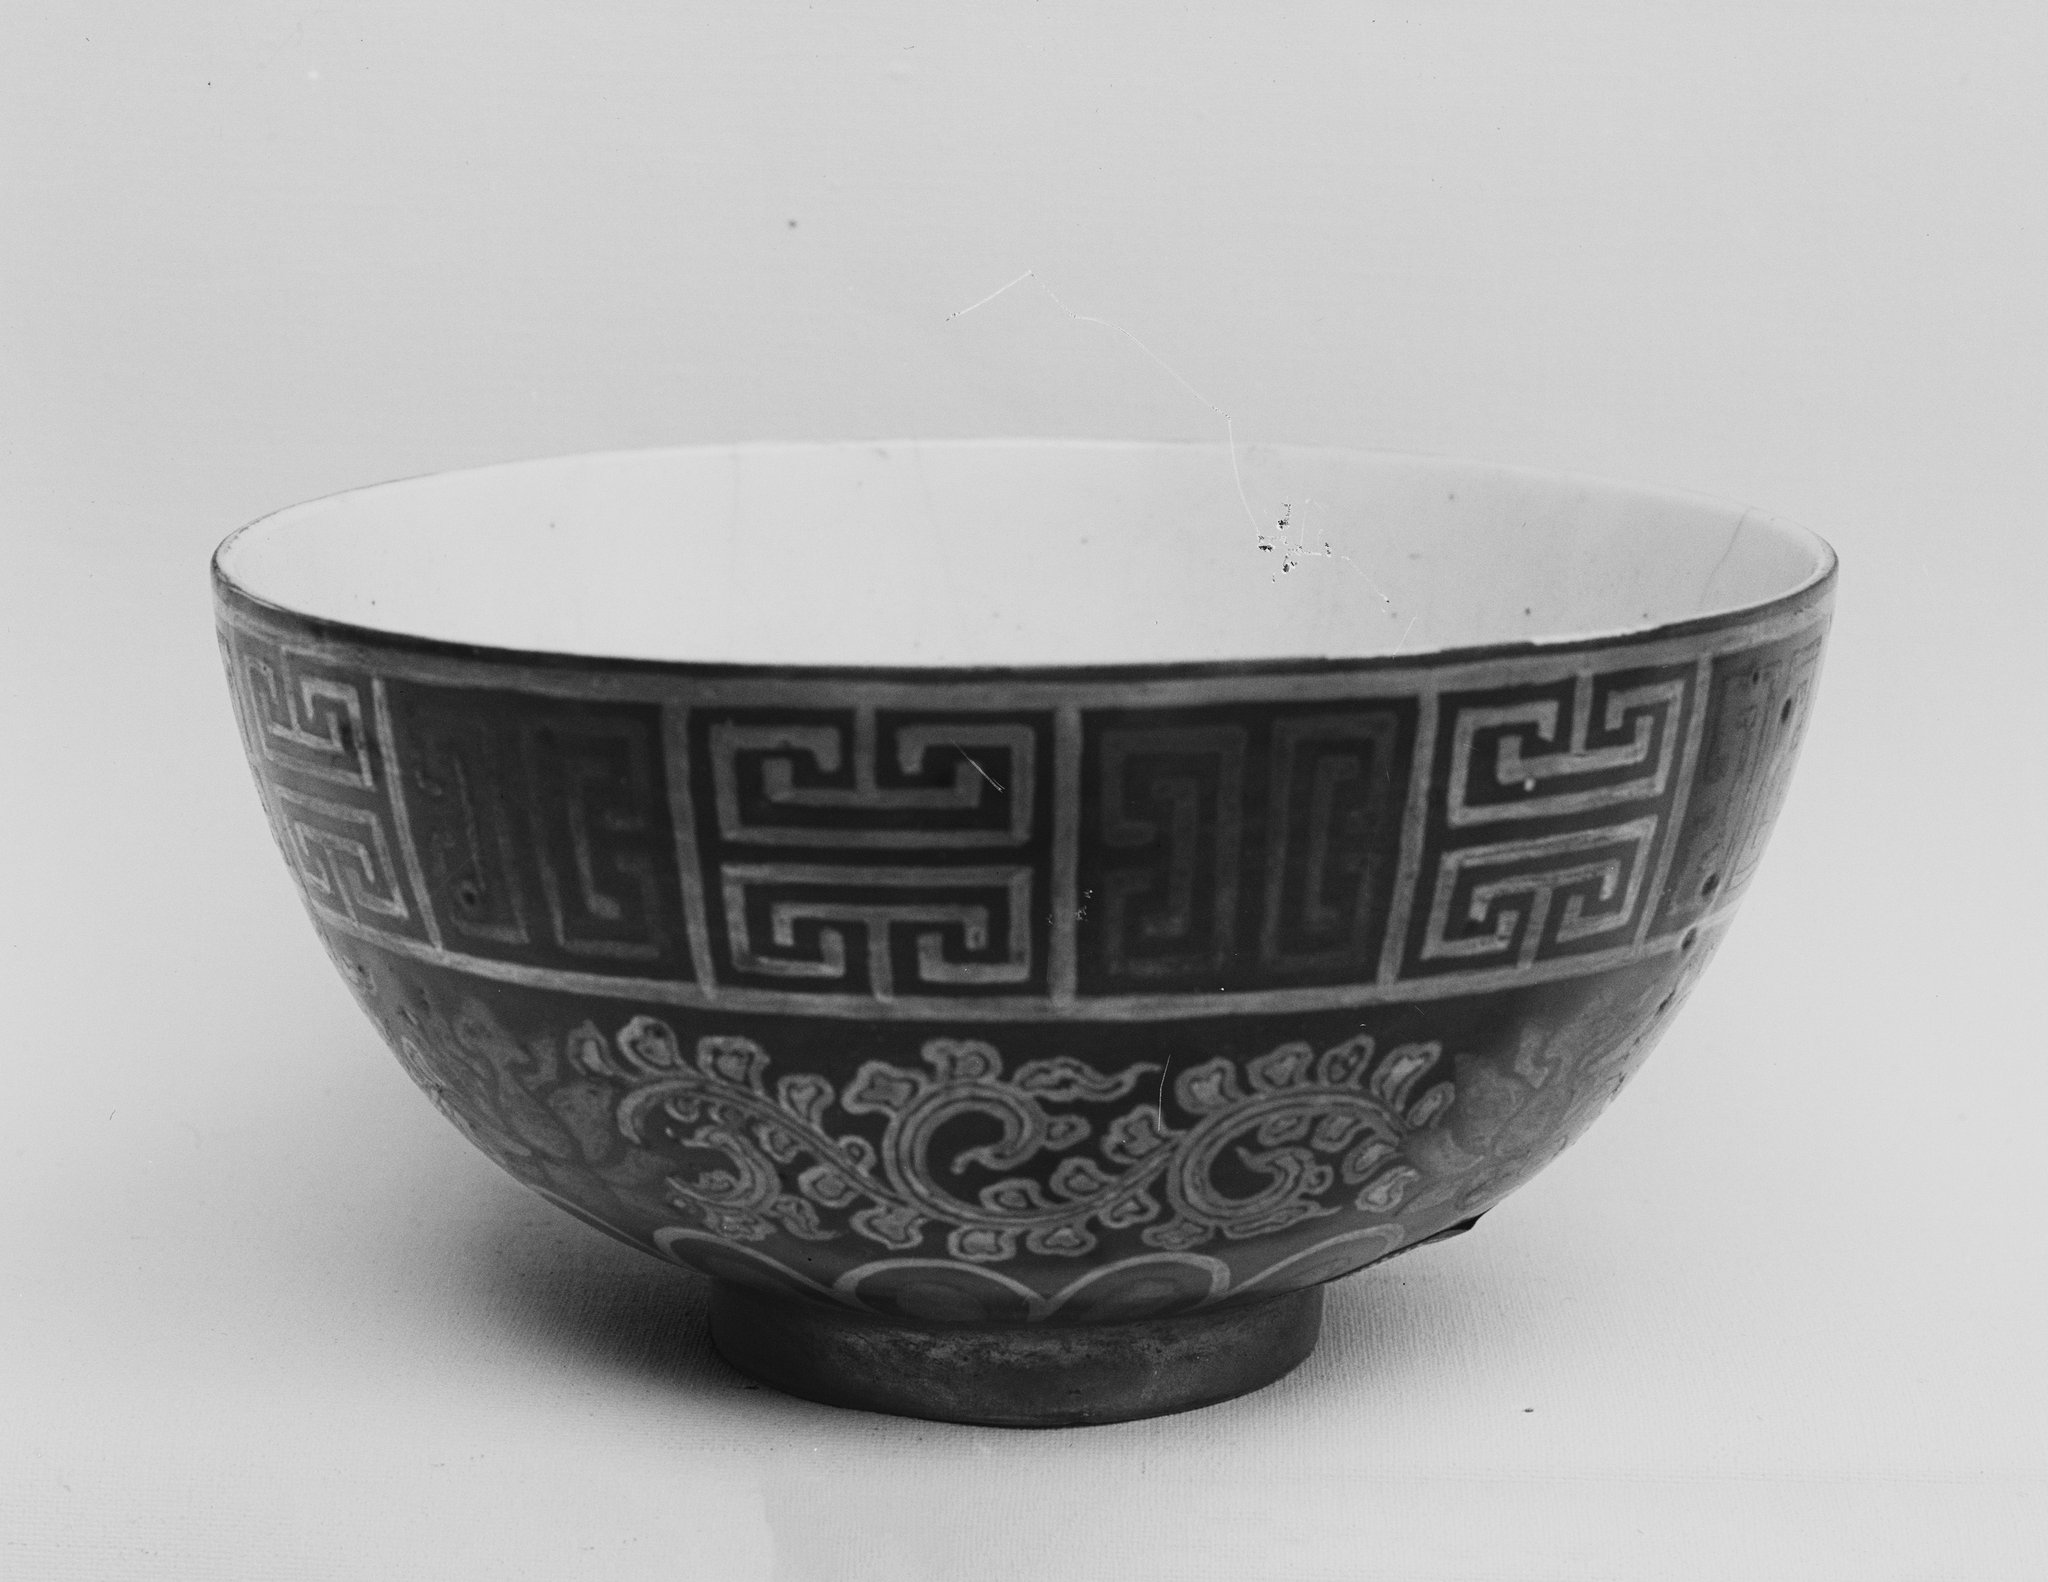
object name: cup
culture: japanese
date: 1700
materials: enamel, gold, soft paste porcelain